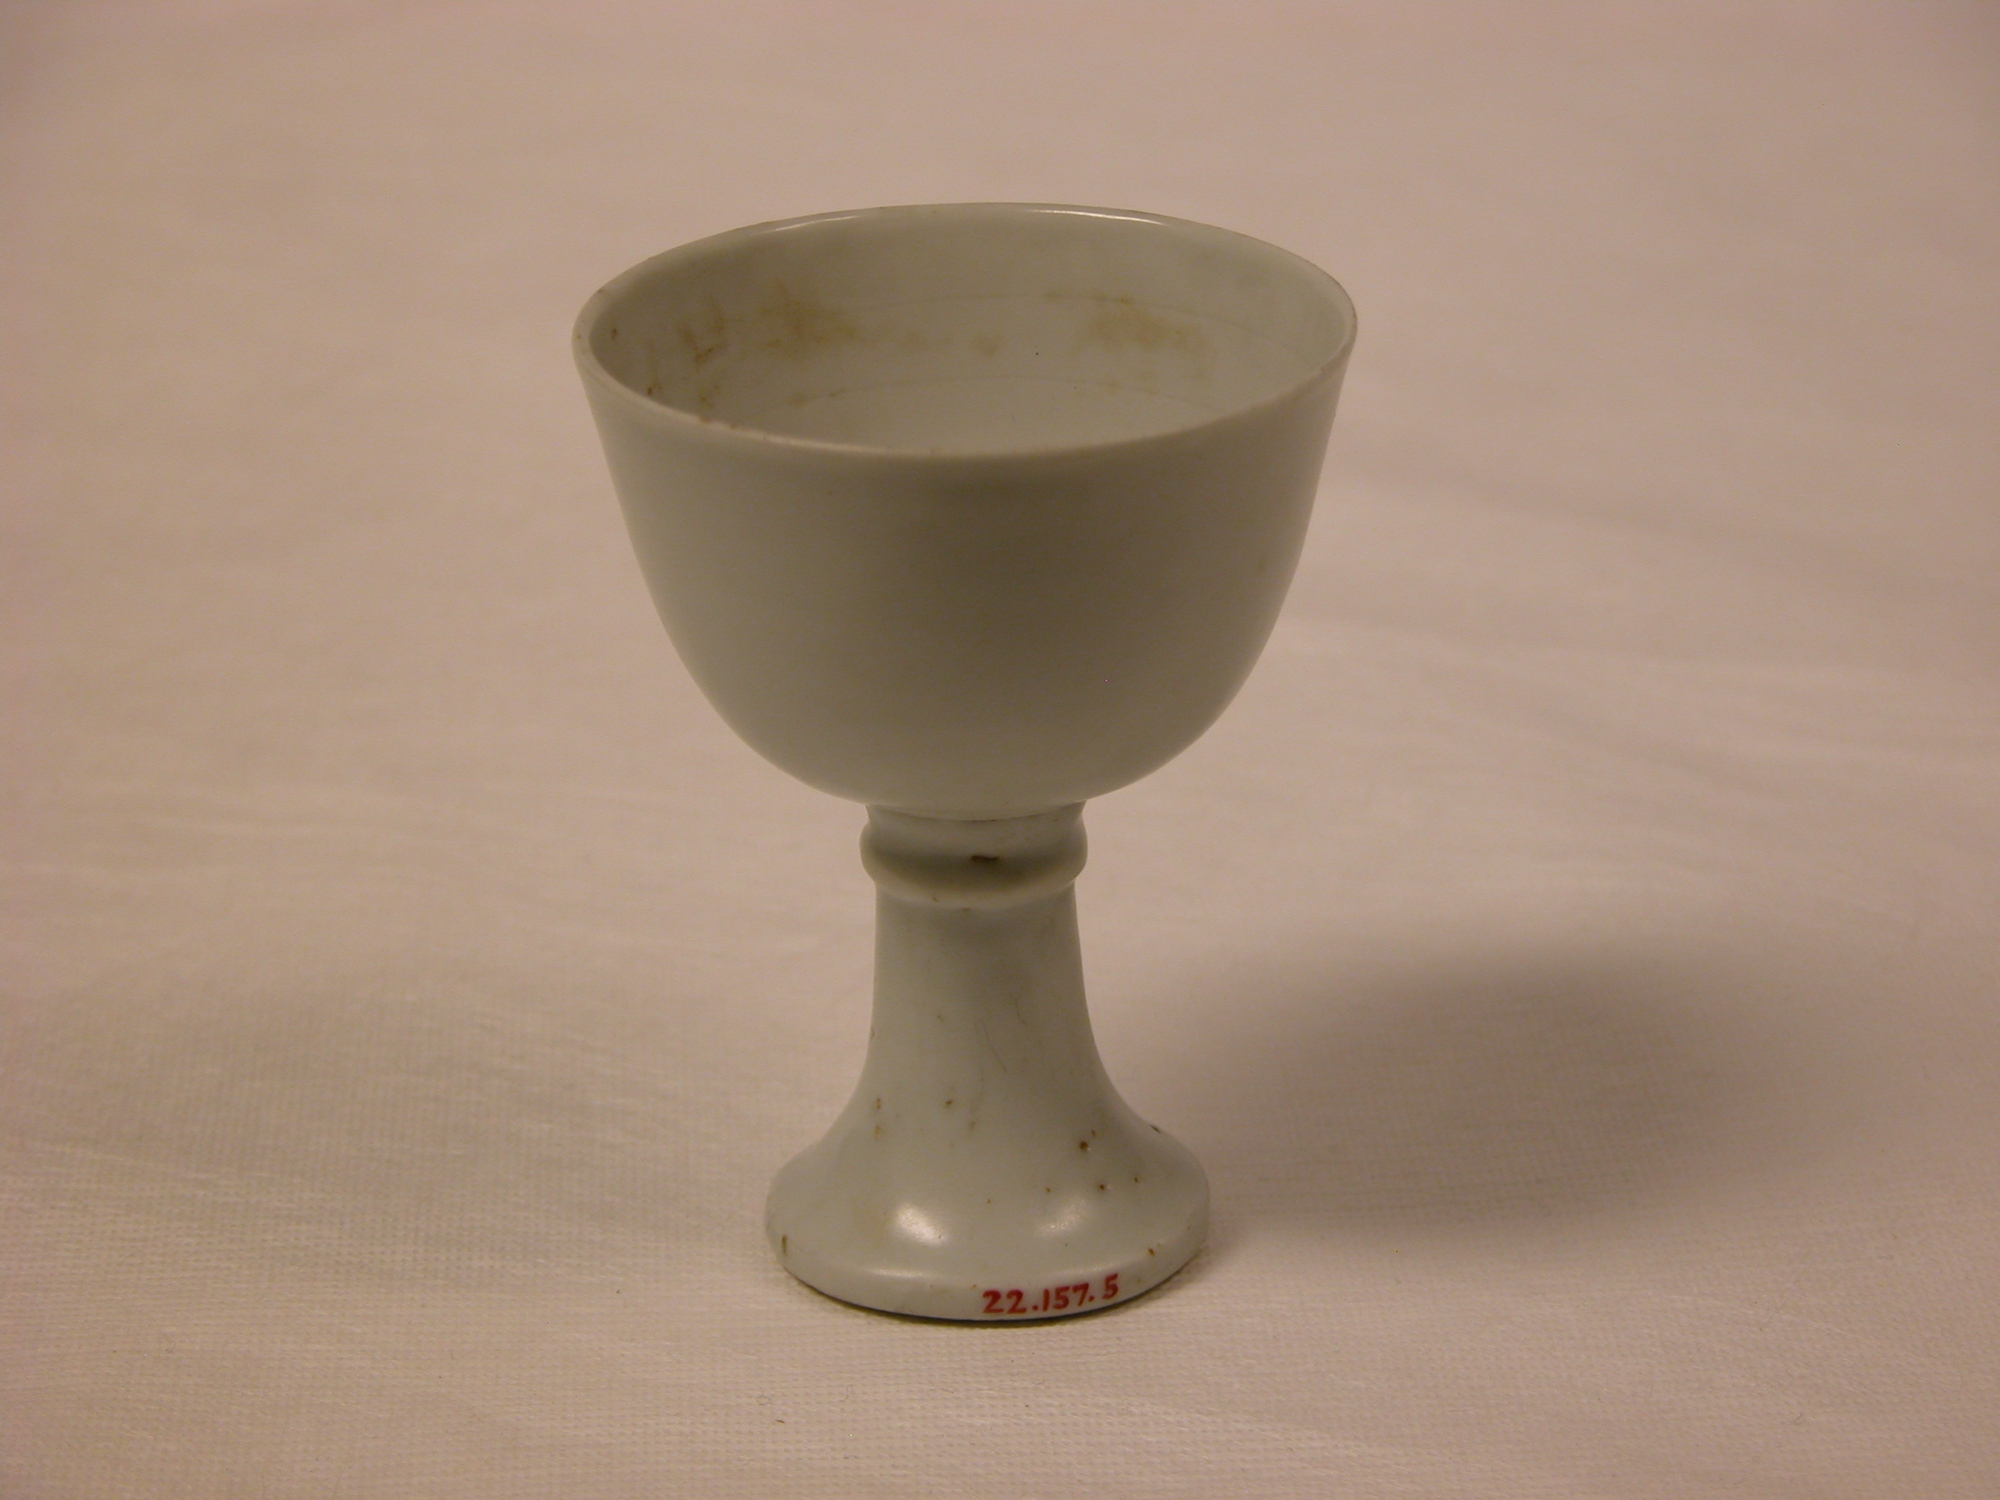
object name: cup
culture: chinese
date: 1279-1368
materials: porcelain